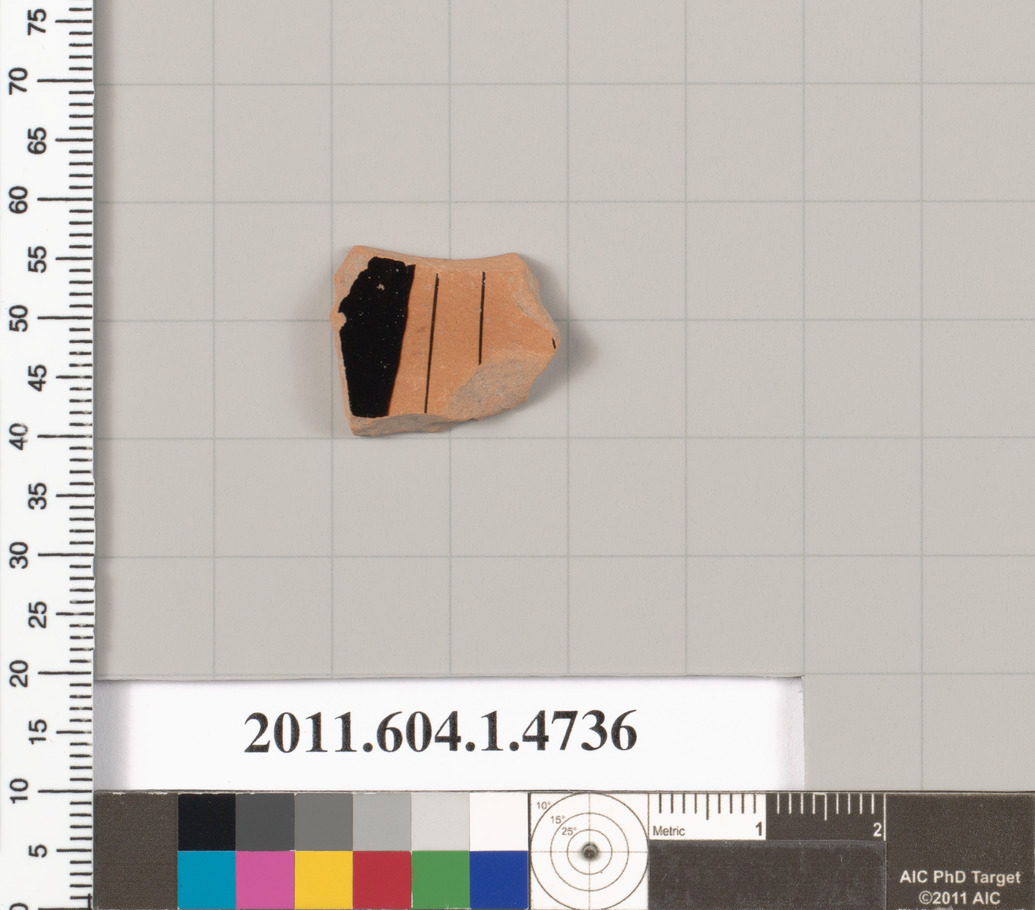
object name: kylix fragment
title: Terracotta fragment of a kylix (drinking cup)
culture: greek, attic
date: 475-451 BCE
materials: terracotta